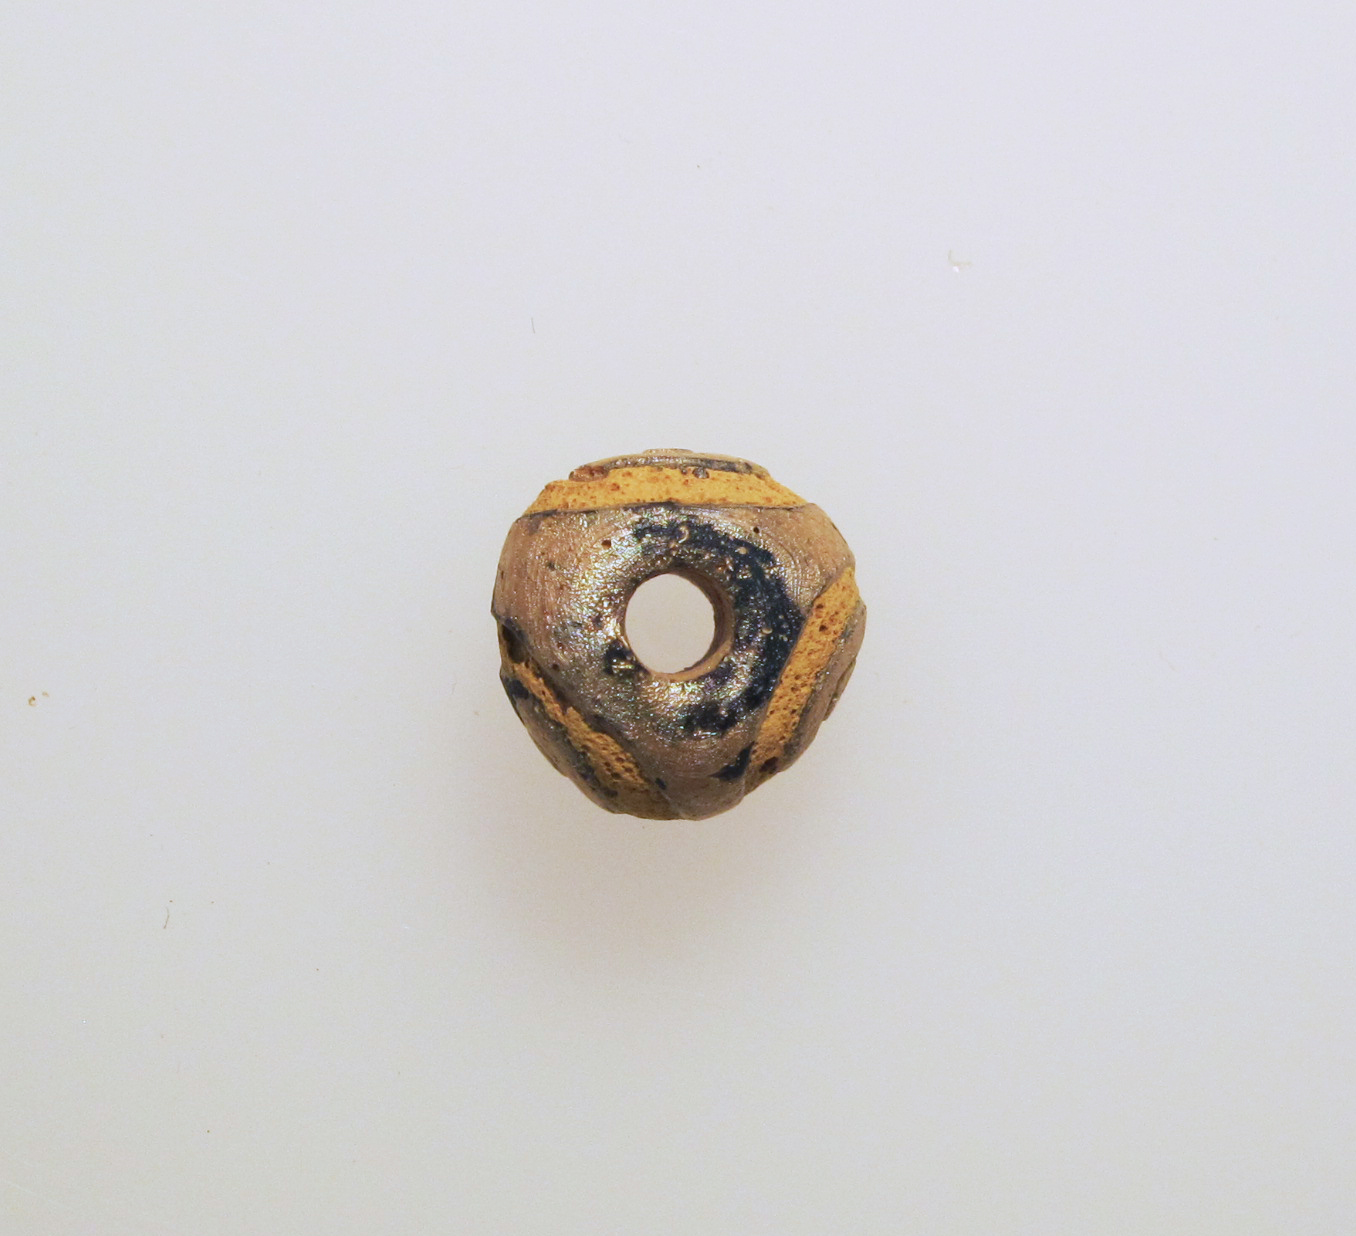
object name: bead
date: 7000 BCE-330 CE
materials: glass